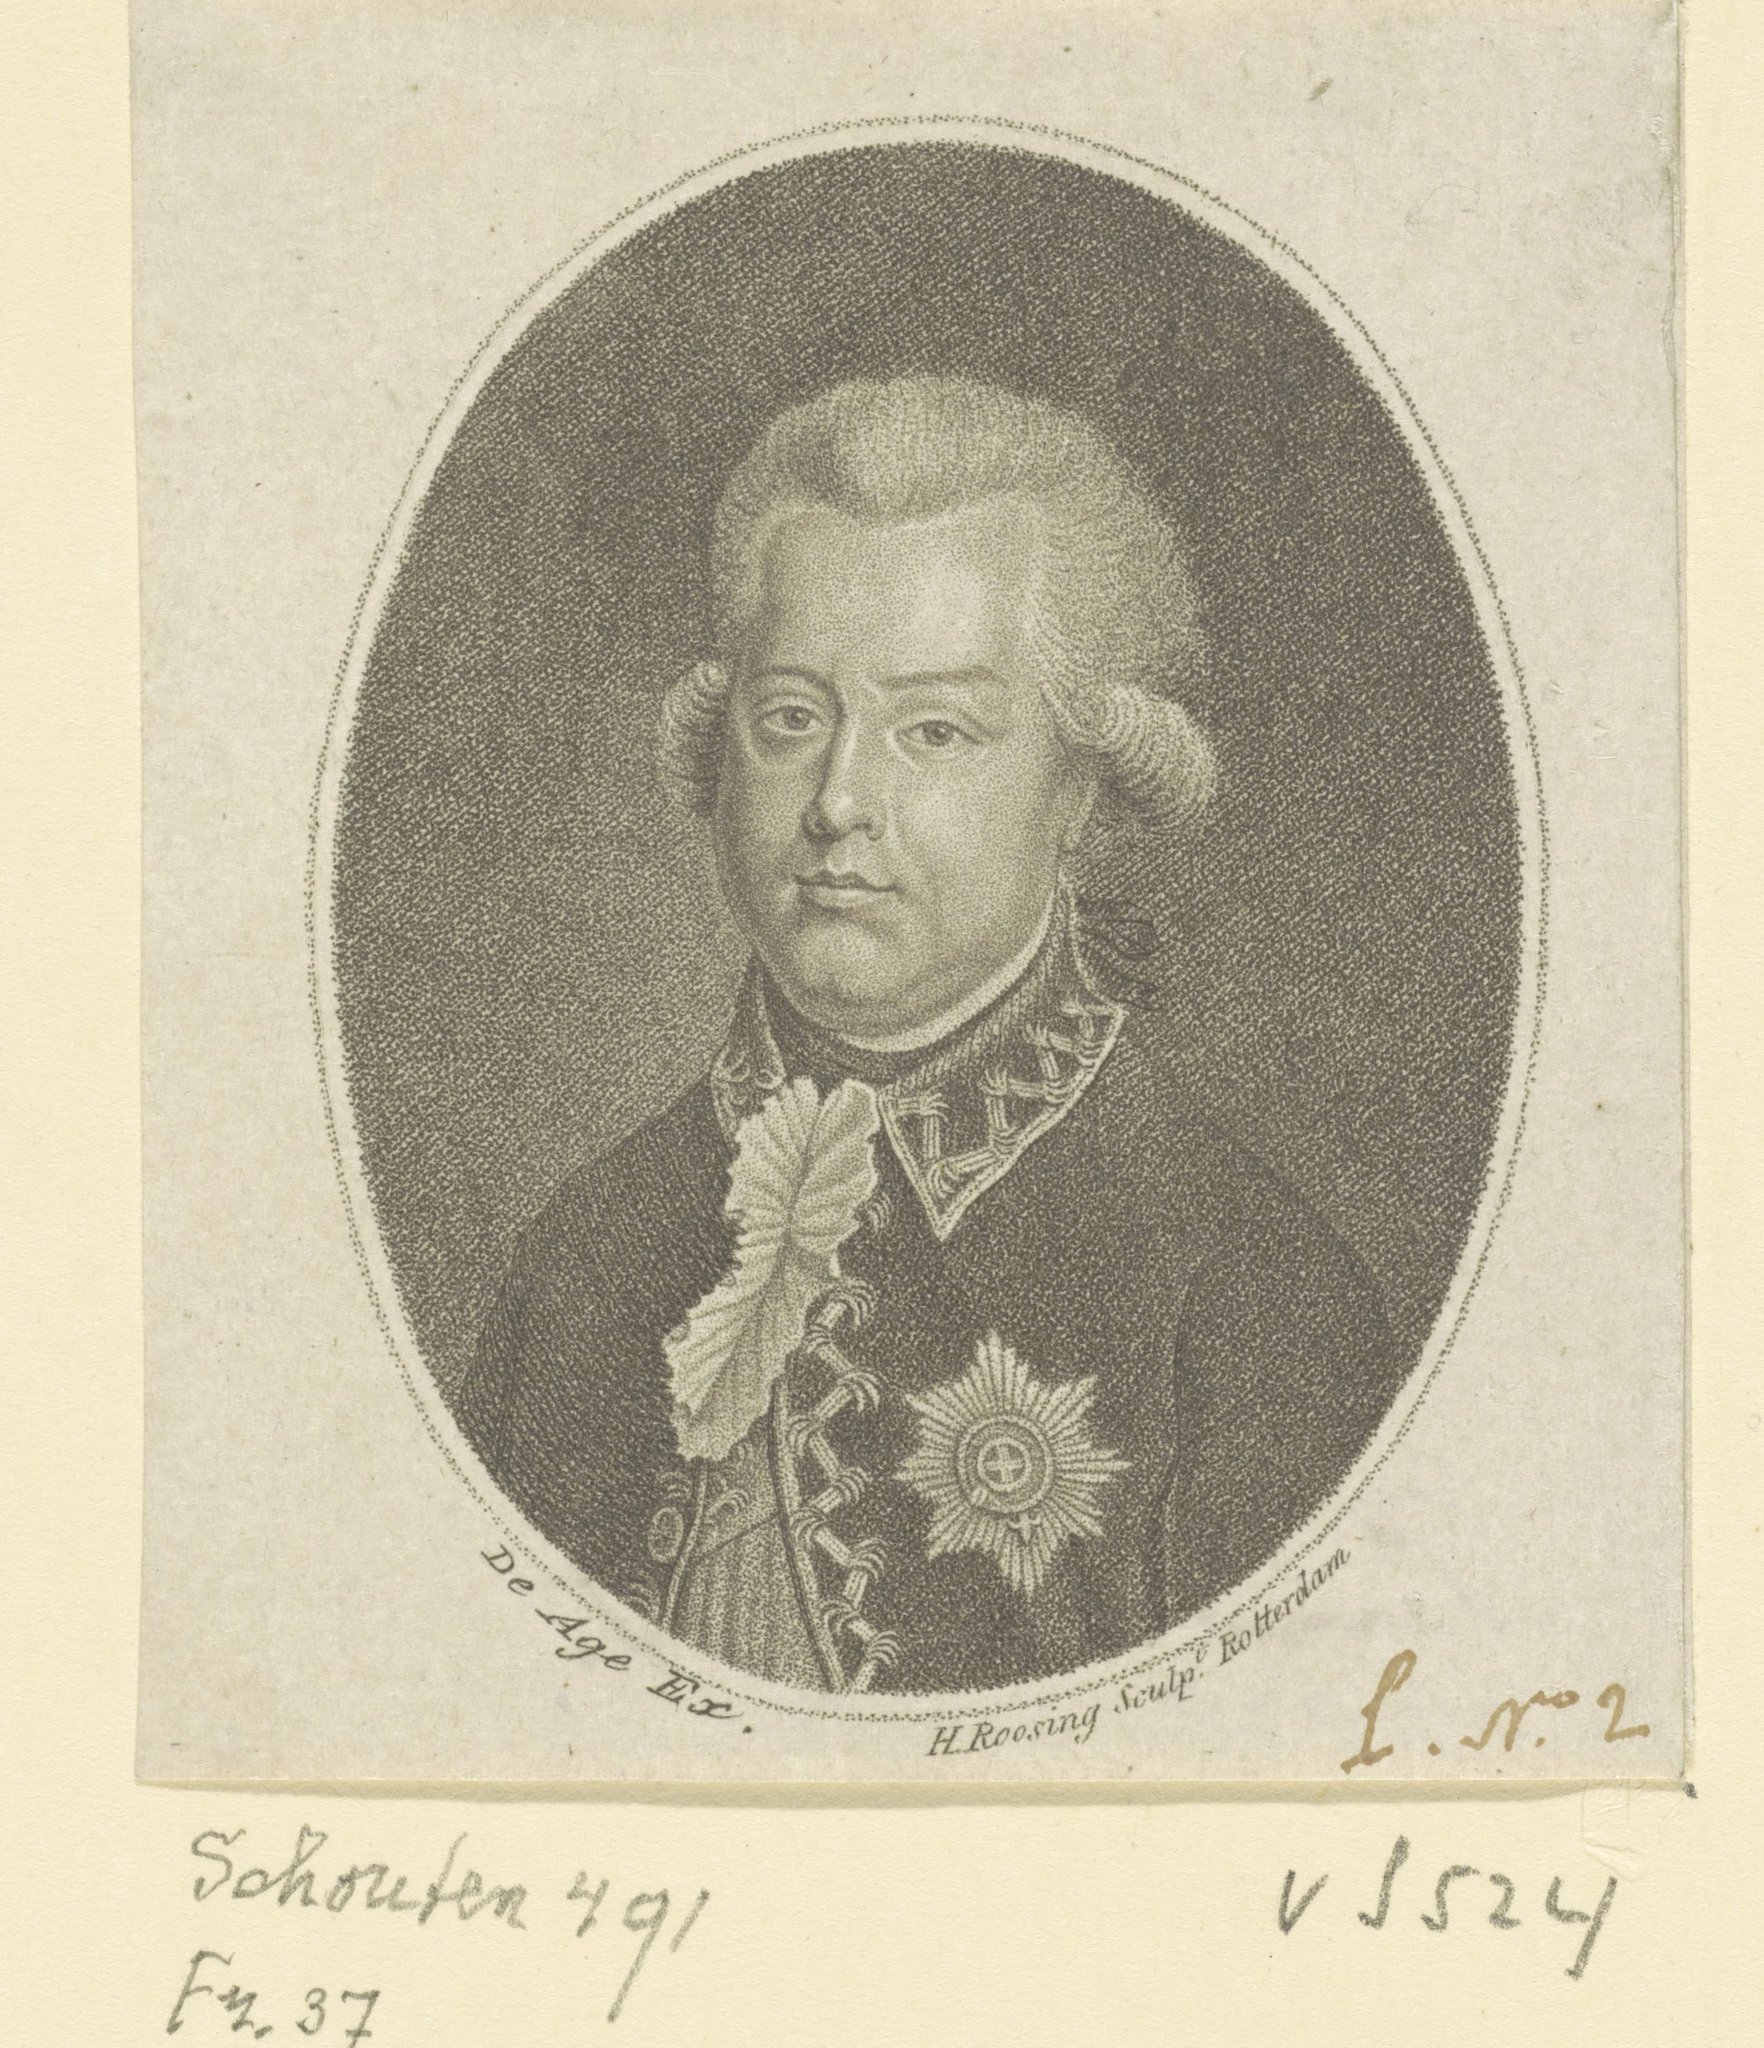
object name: print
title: Portret van Willem V, prins van Oranje-Nassau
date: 1781-1801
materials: paper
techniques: engraving, etching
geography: the hague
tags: the hague, william v (prince of orange), knighthood order (garter) - insignia of a knighthood order, e.g.: badge, chain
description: De hier vermelde titel verwijst naar de hoogst verkregen titel van de geportretteerde, niet per se naar de titel die de geportretteerde op deze voorstelling draagt.